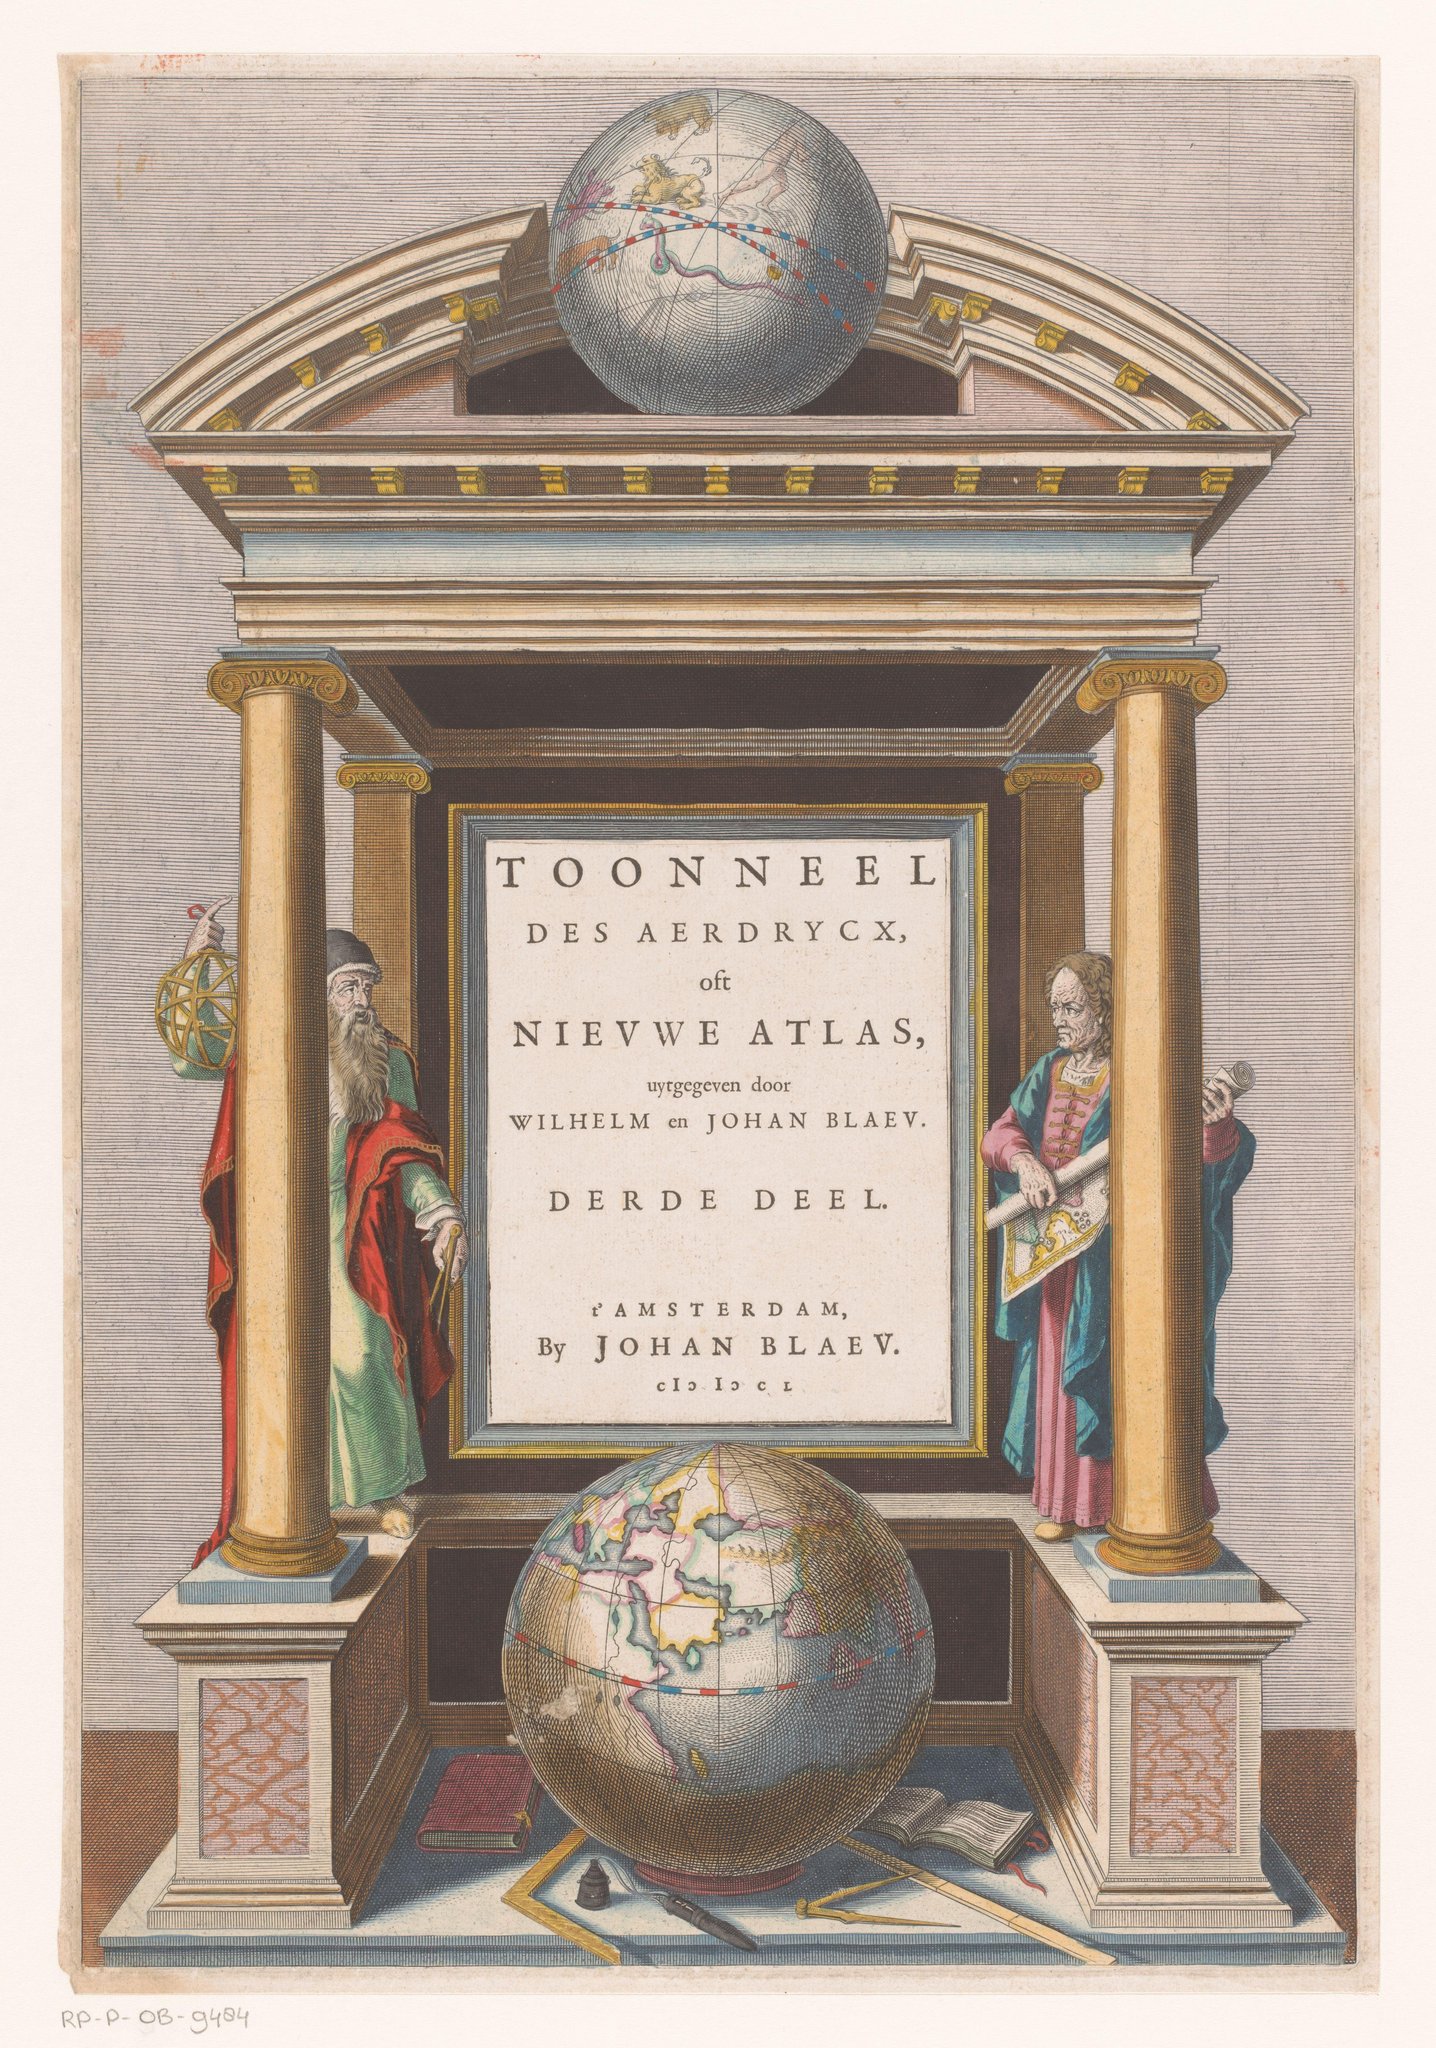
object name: titelblad, titelpagina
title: Portico met globes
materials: paper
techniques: engraving, hand coloring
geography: amsterdam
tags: monumental door, porch, 'aediculum', globe, star-globe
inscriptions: collector's mark: Lugt 2228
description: Ionische portico met twee hemel- en een aardglobe. Links staat Claudius Ptolemaeus met een armillarium en een passer, rechts staat Marinus van Tyrus met een kaart.